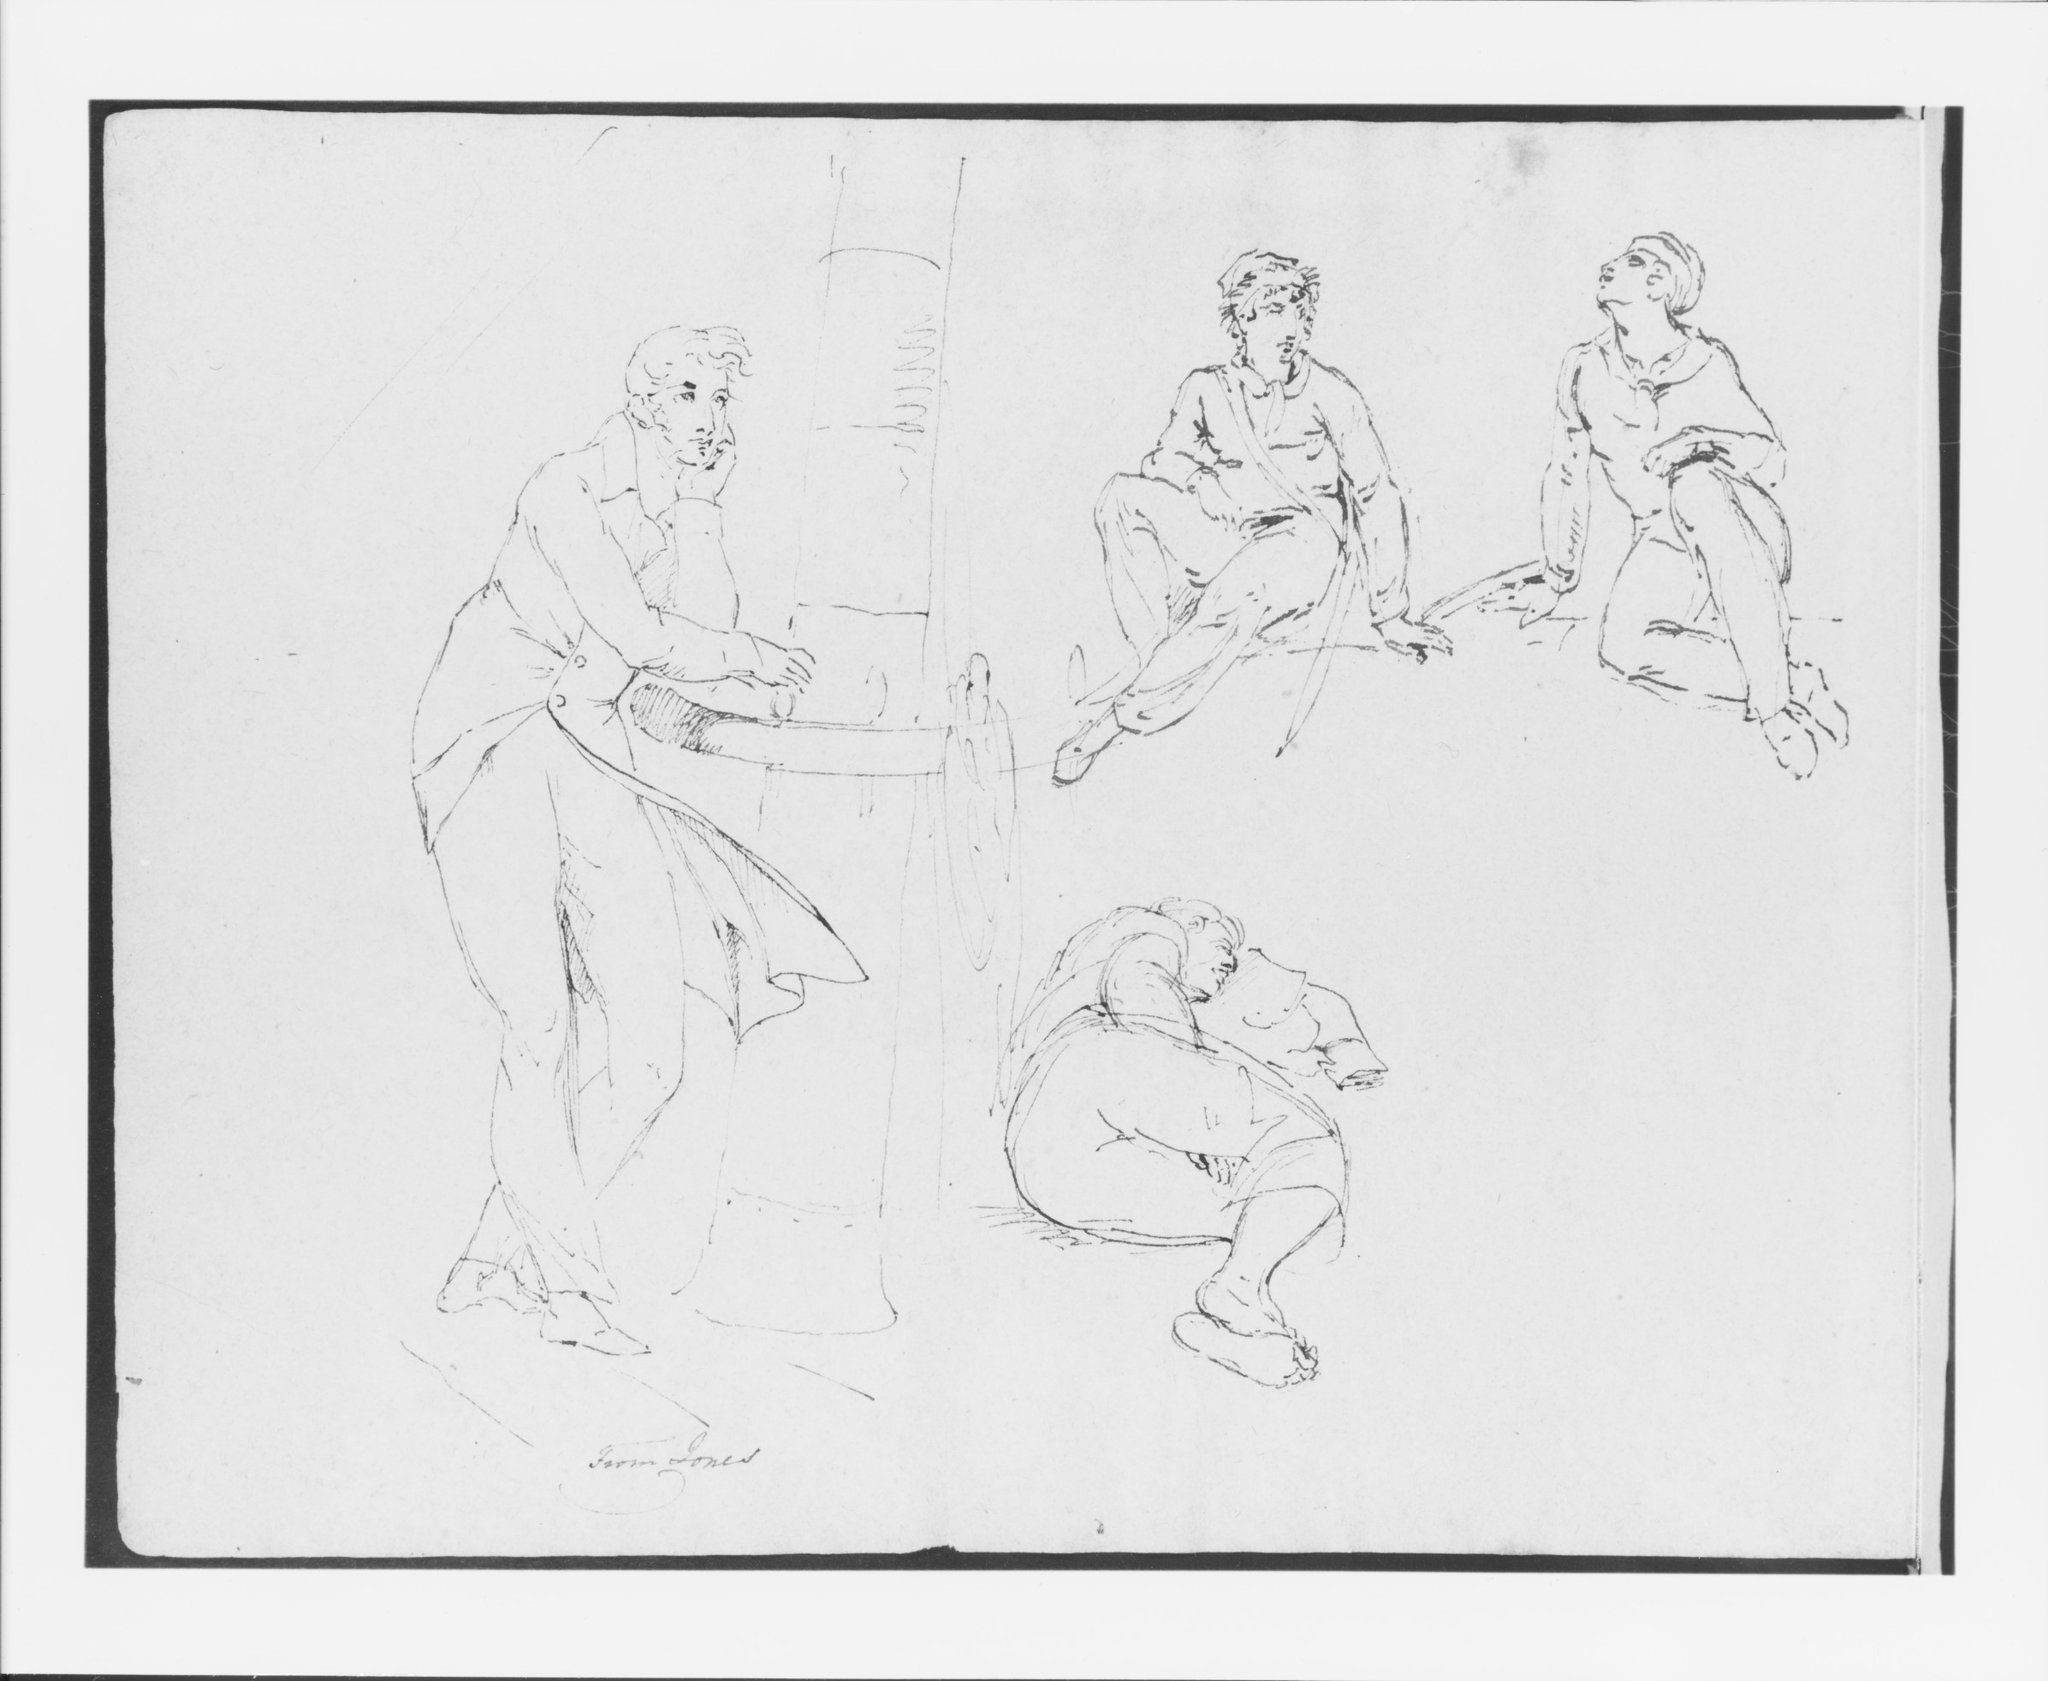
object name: drawing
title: Two Seated Figures; One Sleeping Figure; Standing Man Leaning on Ship Railing (from Sketchbook)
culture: american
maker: thomas sully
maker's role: artist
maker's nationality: american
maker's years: 1783-1872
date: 1810-1820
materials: ink, paper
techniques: wash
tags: sleeping,men